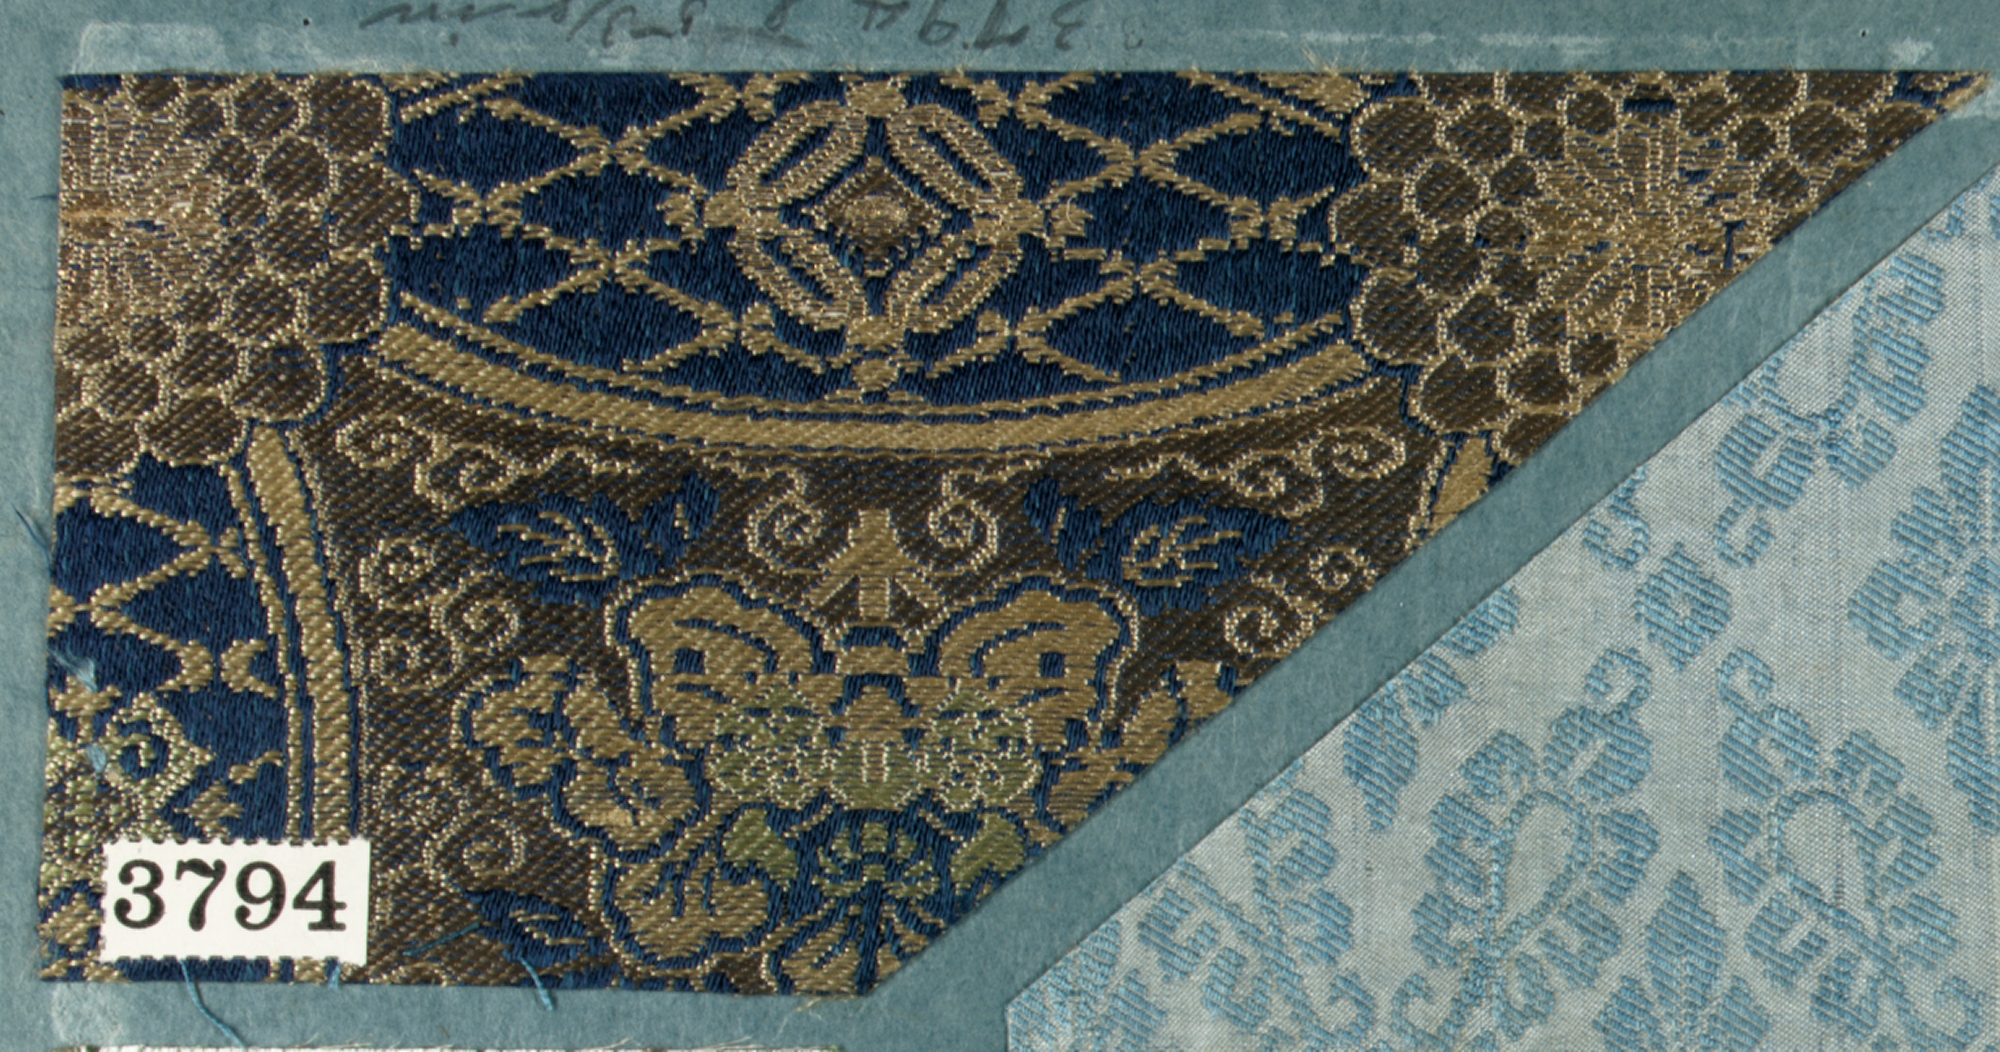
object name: sample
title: Textile Sample from Sample Book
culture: japanese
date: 1801-1900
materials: silk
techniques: tapestry